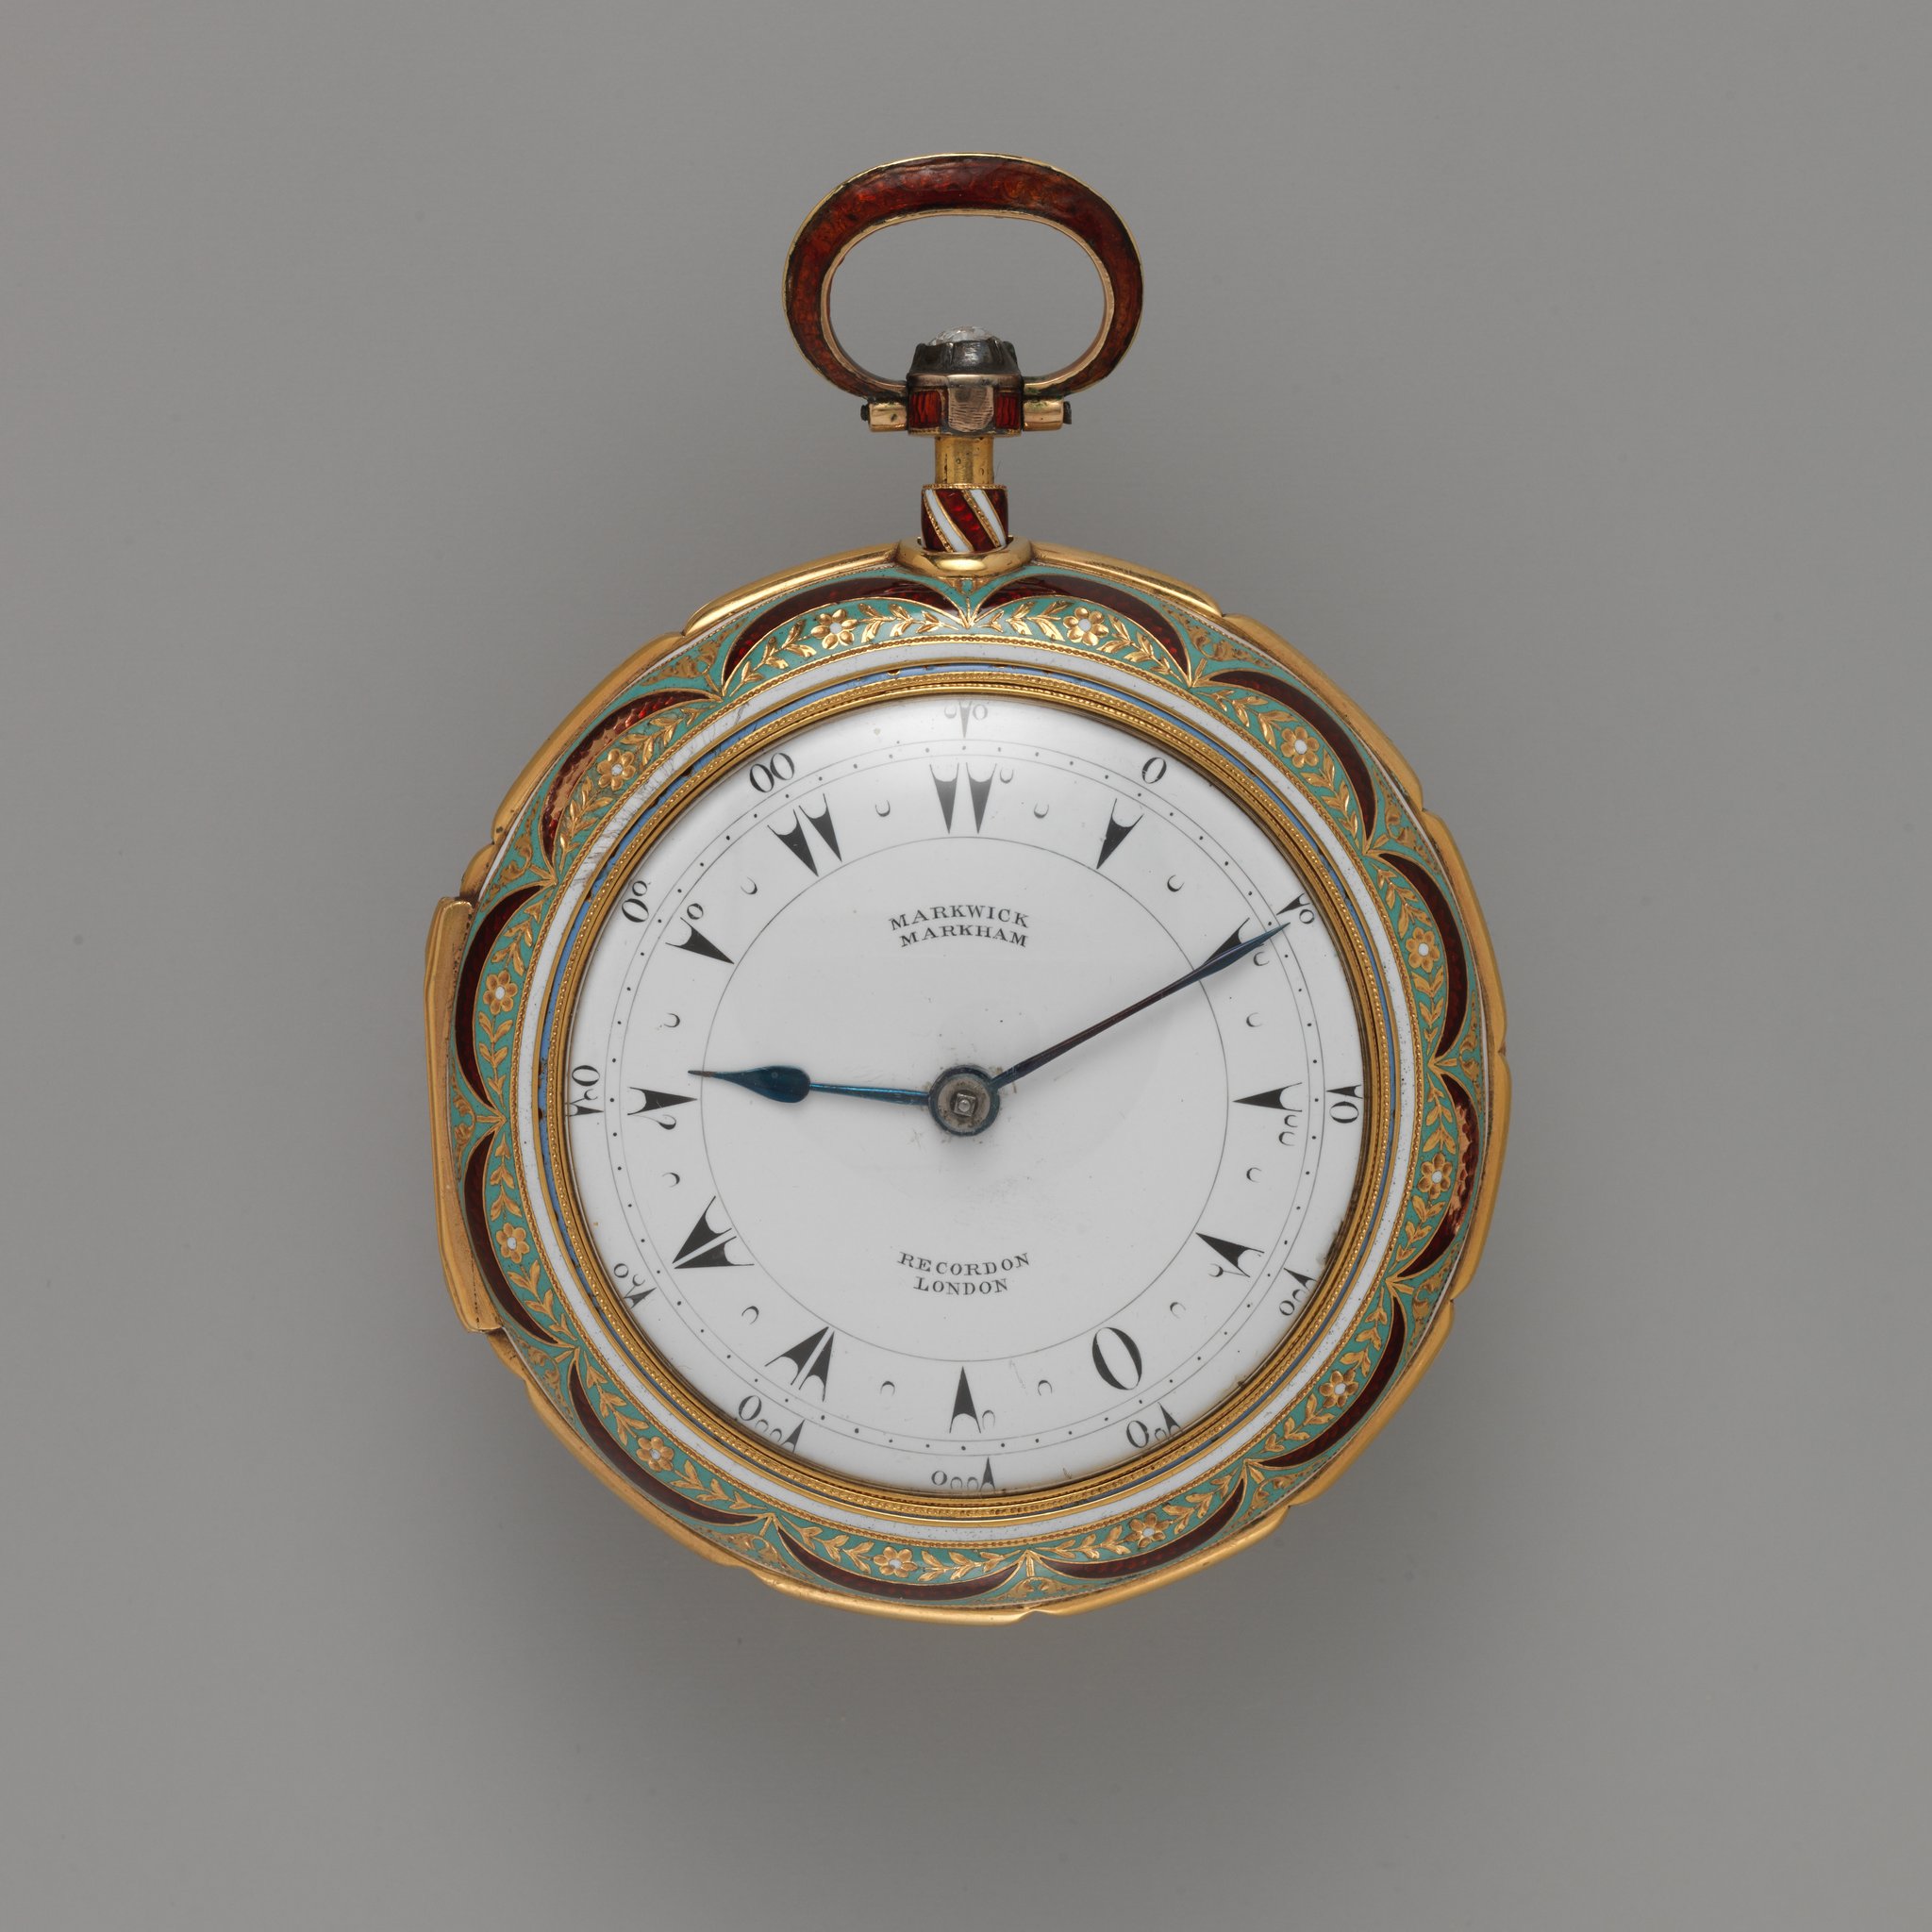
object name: repeating watch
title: Triple-case repeating watch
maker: firm of marwick, markham and recordon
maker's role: maker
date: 1798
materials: diamond, enamel, gold